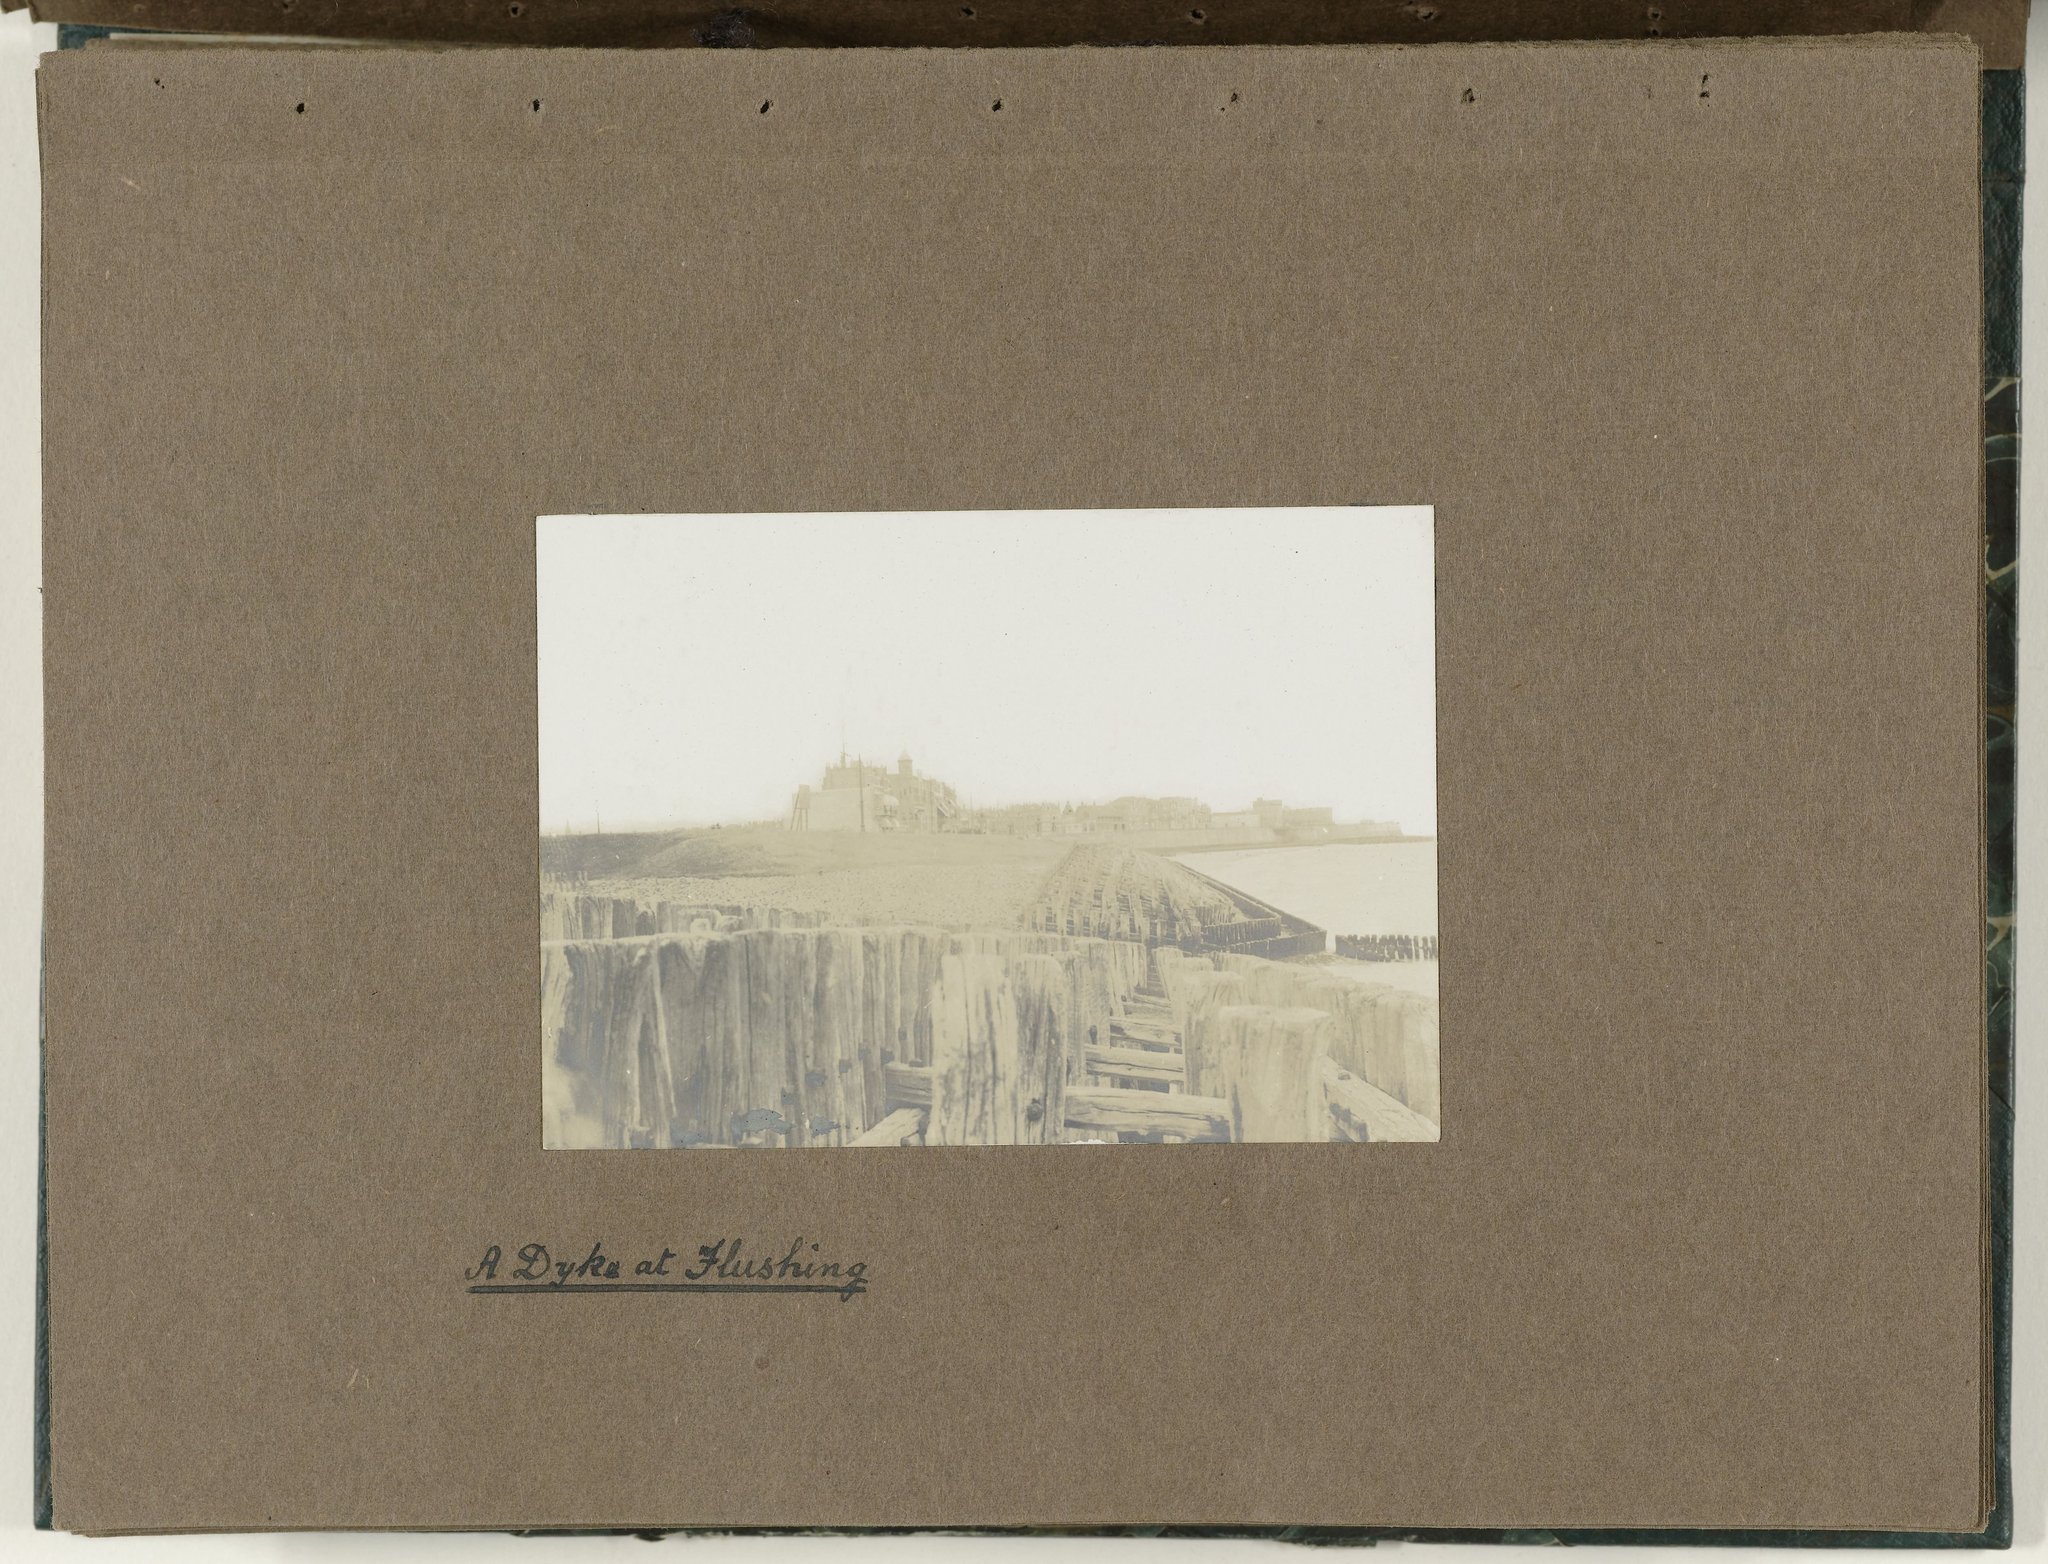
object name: album leaf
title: Plattegrond van door amateurfotografenvereniging P.C.U.K. bezochte steden in Nederland en België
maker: Anonymous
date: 1912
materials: ink, paper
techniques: letterpress printing, writing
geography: great britain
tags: maps, atlases, netherlands, belgium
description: De plaatsen die door de leden van de Britse amateurfotografenvereniging P.C.U.K. tijdens hun excursie naar Nederland bezocht werden, zijn rood onderstreept. Onderdeel van Fotoalbum van de excursie naar Nederland van de Britse amateurfotografenvereniging P.C.U.K.